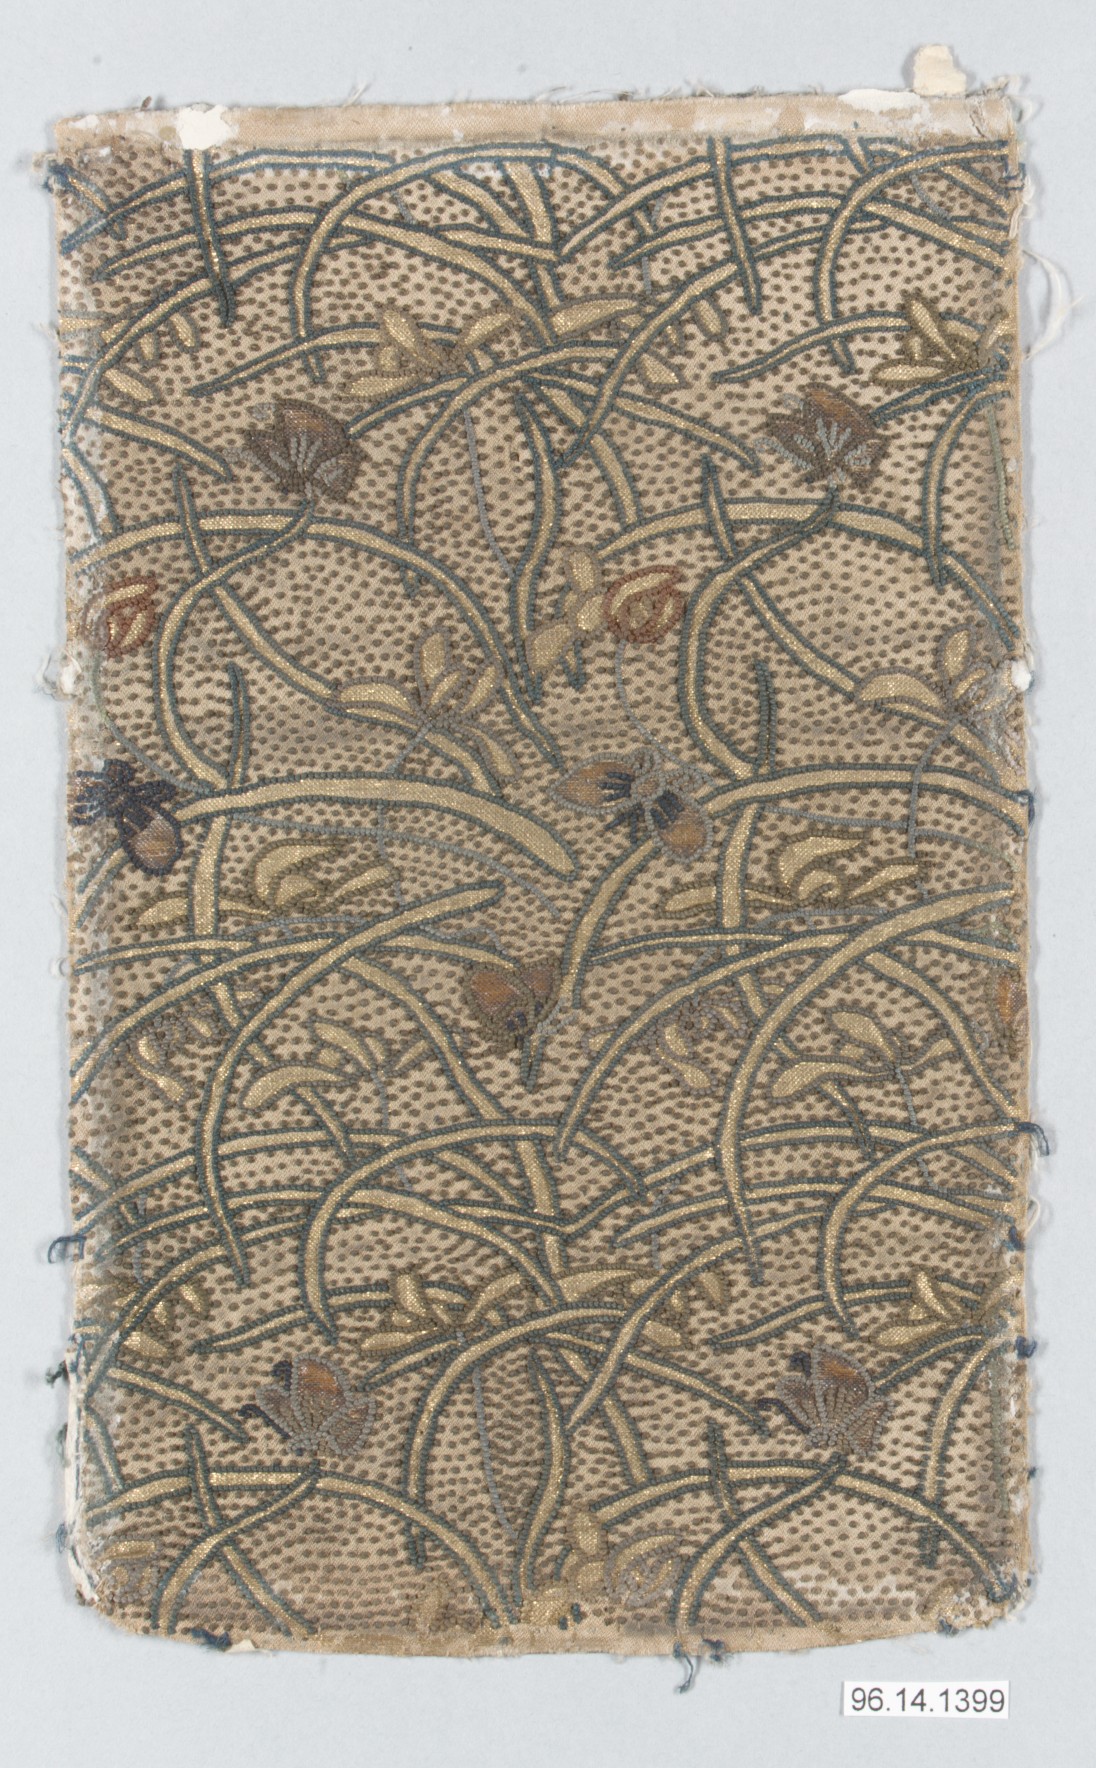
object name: piece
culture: japanese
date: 1701-1800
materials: metal thread, silk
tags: butterflies